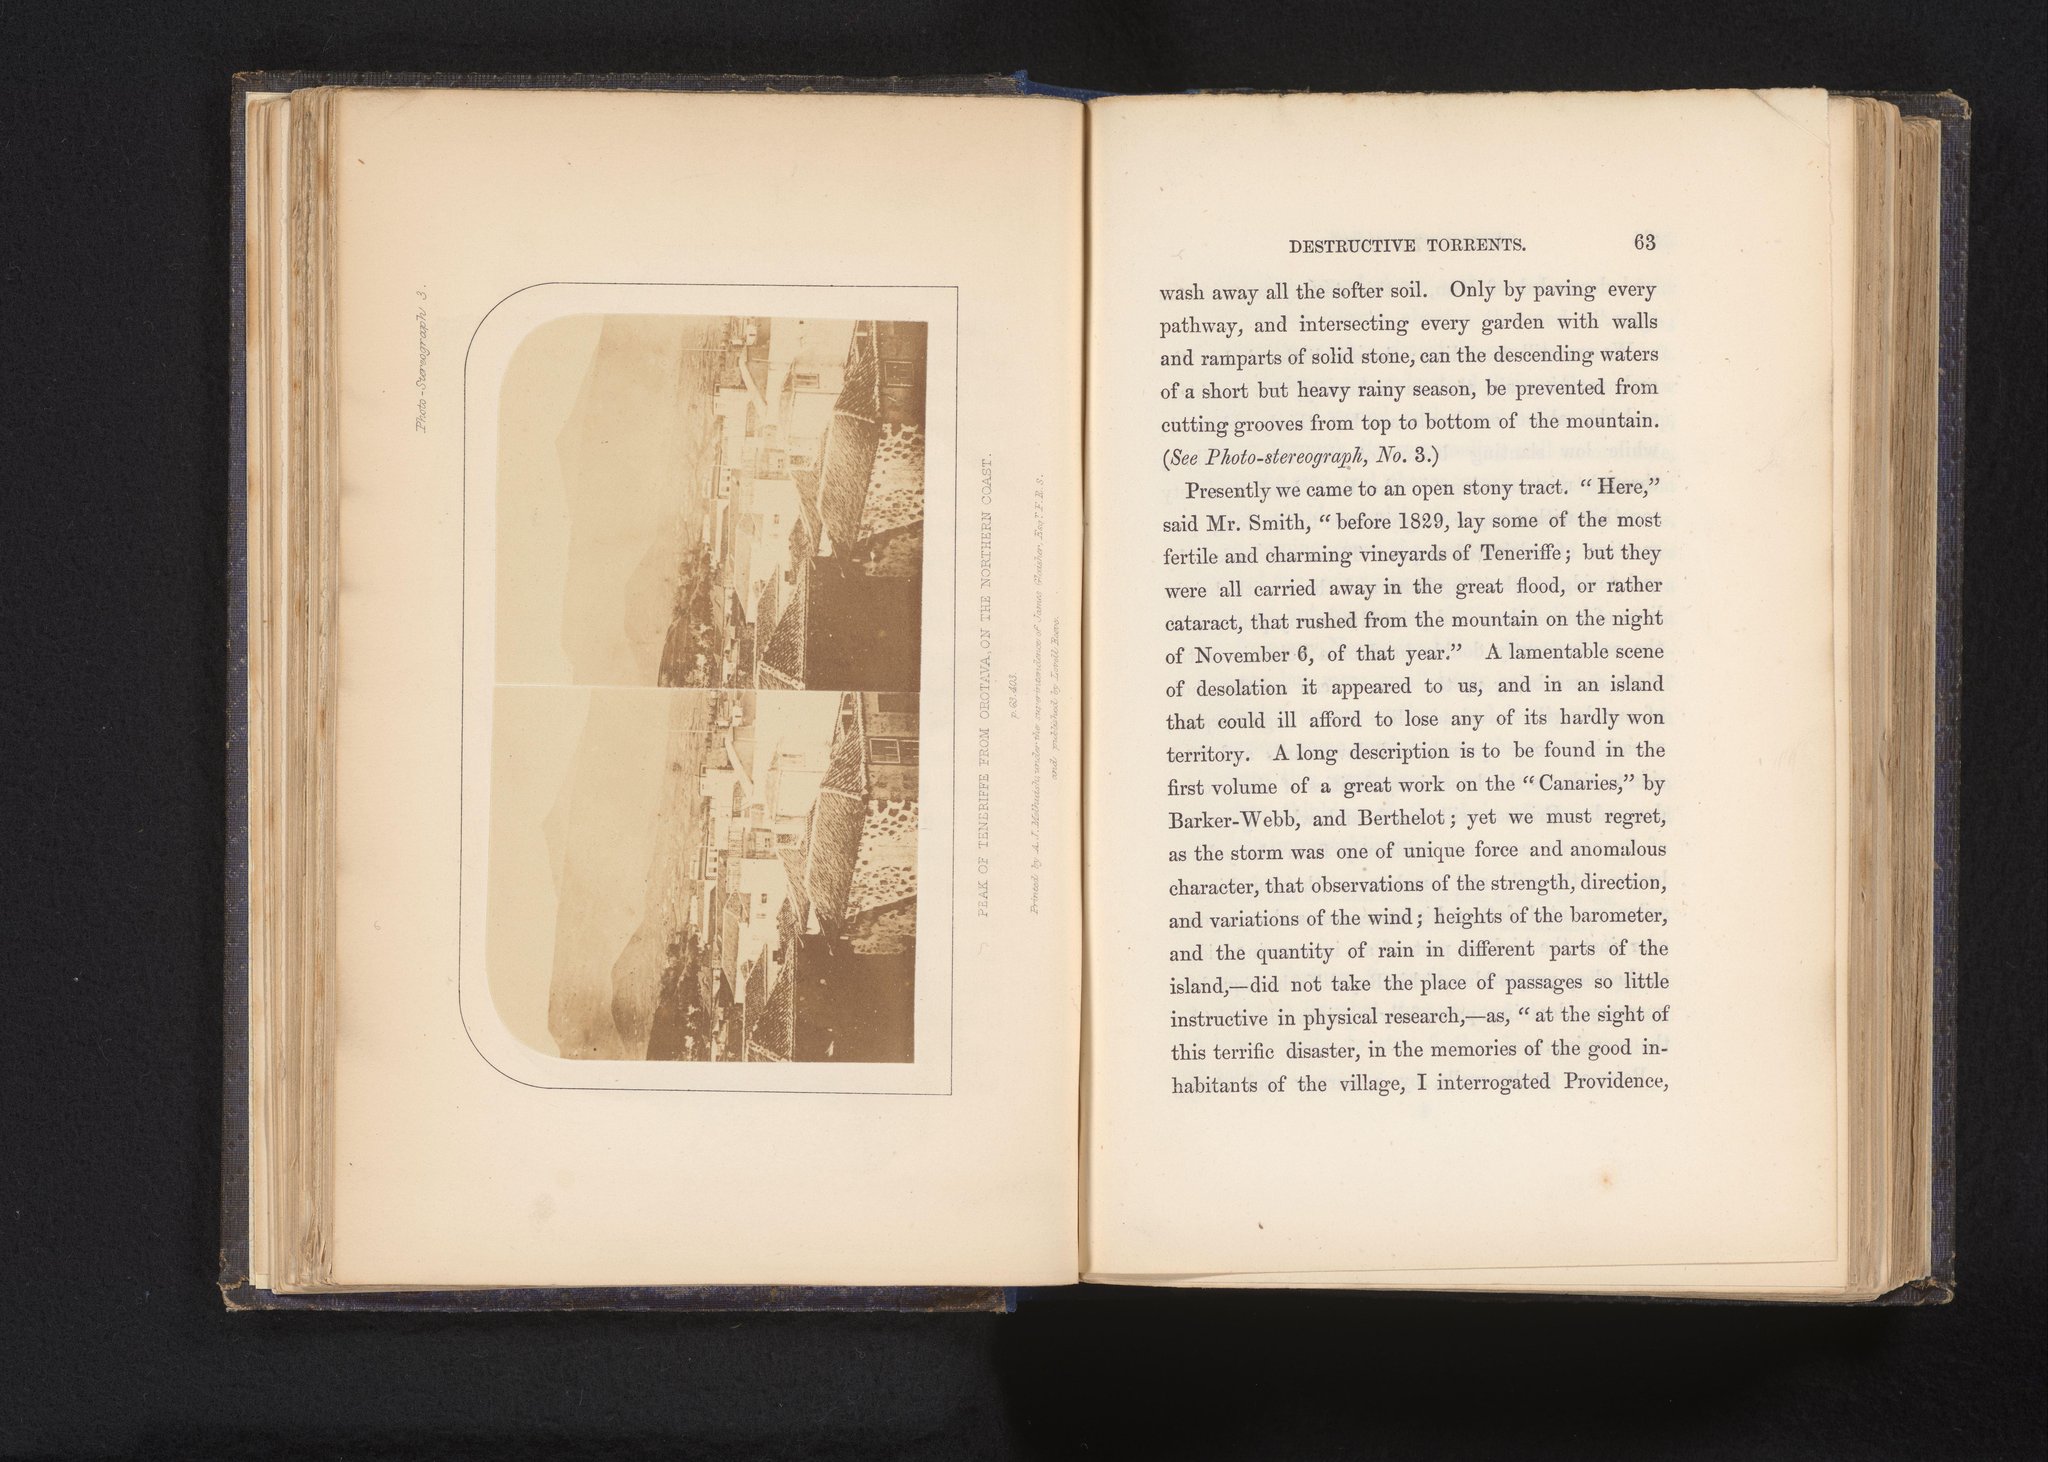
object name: stereograph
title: Peak of Teneriffe from Orotava, from the northern coast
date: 1856-1858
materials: paper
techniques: albumen print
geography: london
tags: city-view in general; 'veduta', volcano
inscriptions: inscription: ‘Photo-Stereograph 3.’